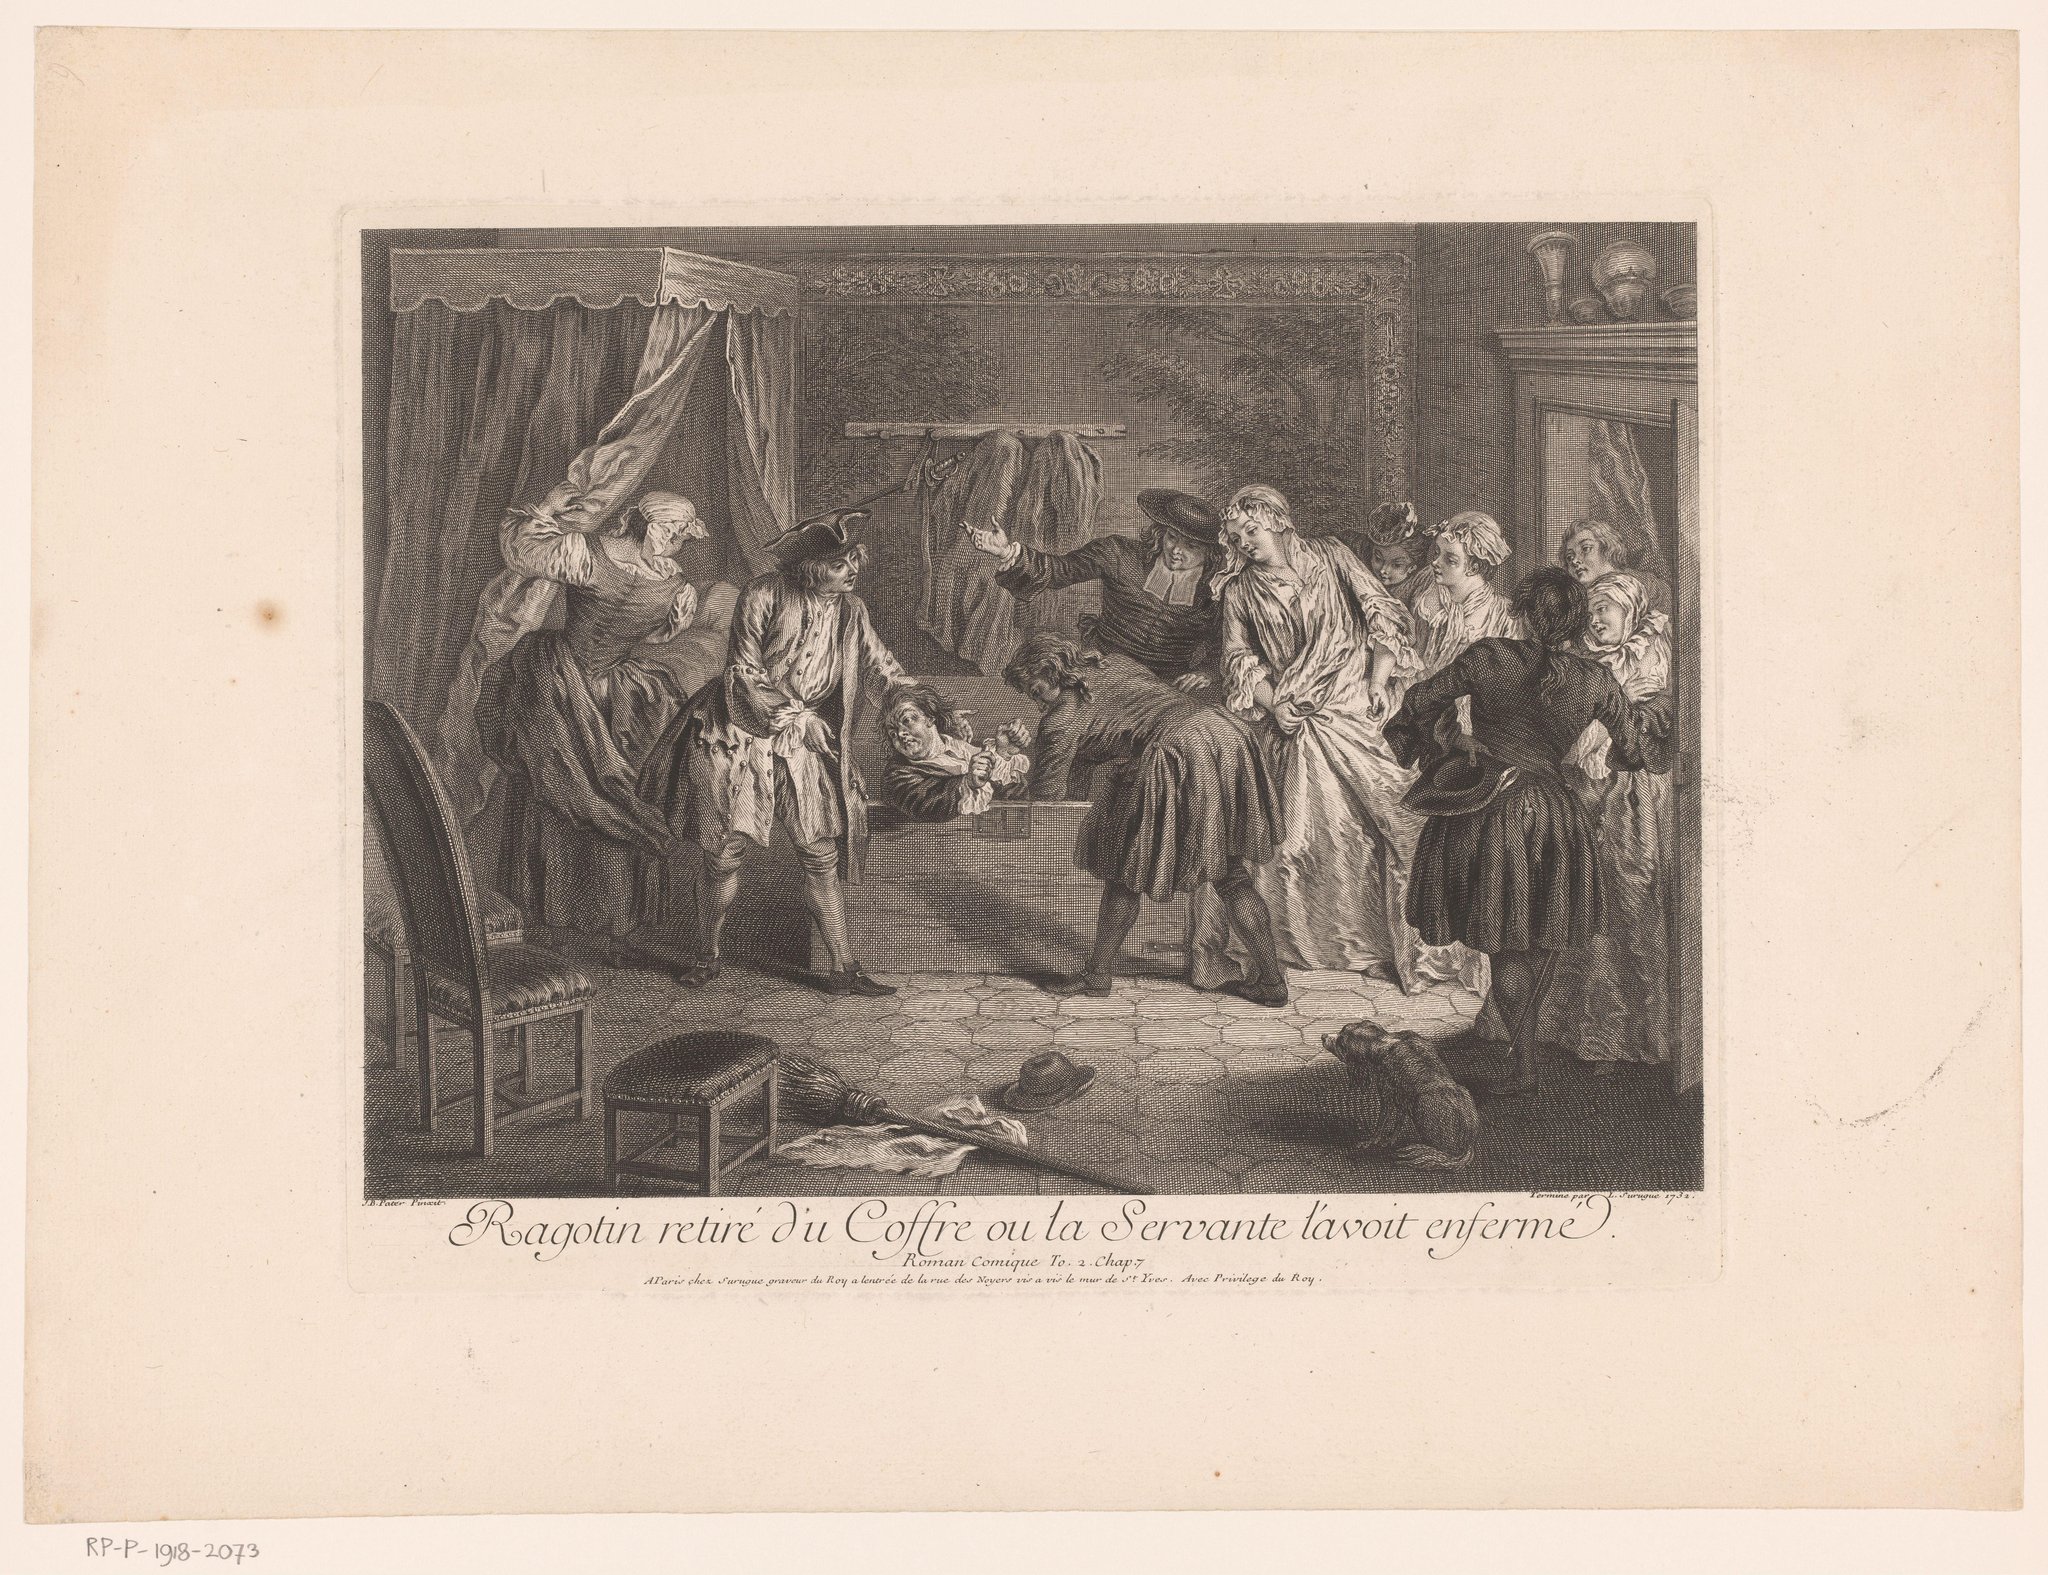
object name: print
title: Slaapkamerinterieur met gezelschap en Ragotin in een kist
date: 1732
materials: paper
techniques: engraving, etching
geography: france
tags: (scarron, roman comique) specific works of literature (with author, title), chest, coffer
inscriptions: collector's mark: Lugt 2233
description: Serie van 16 prenten bij de Roman Comique van Scarron, waarvan een aantal door Louis en Pierre Louis Surugue.